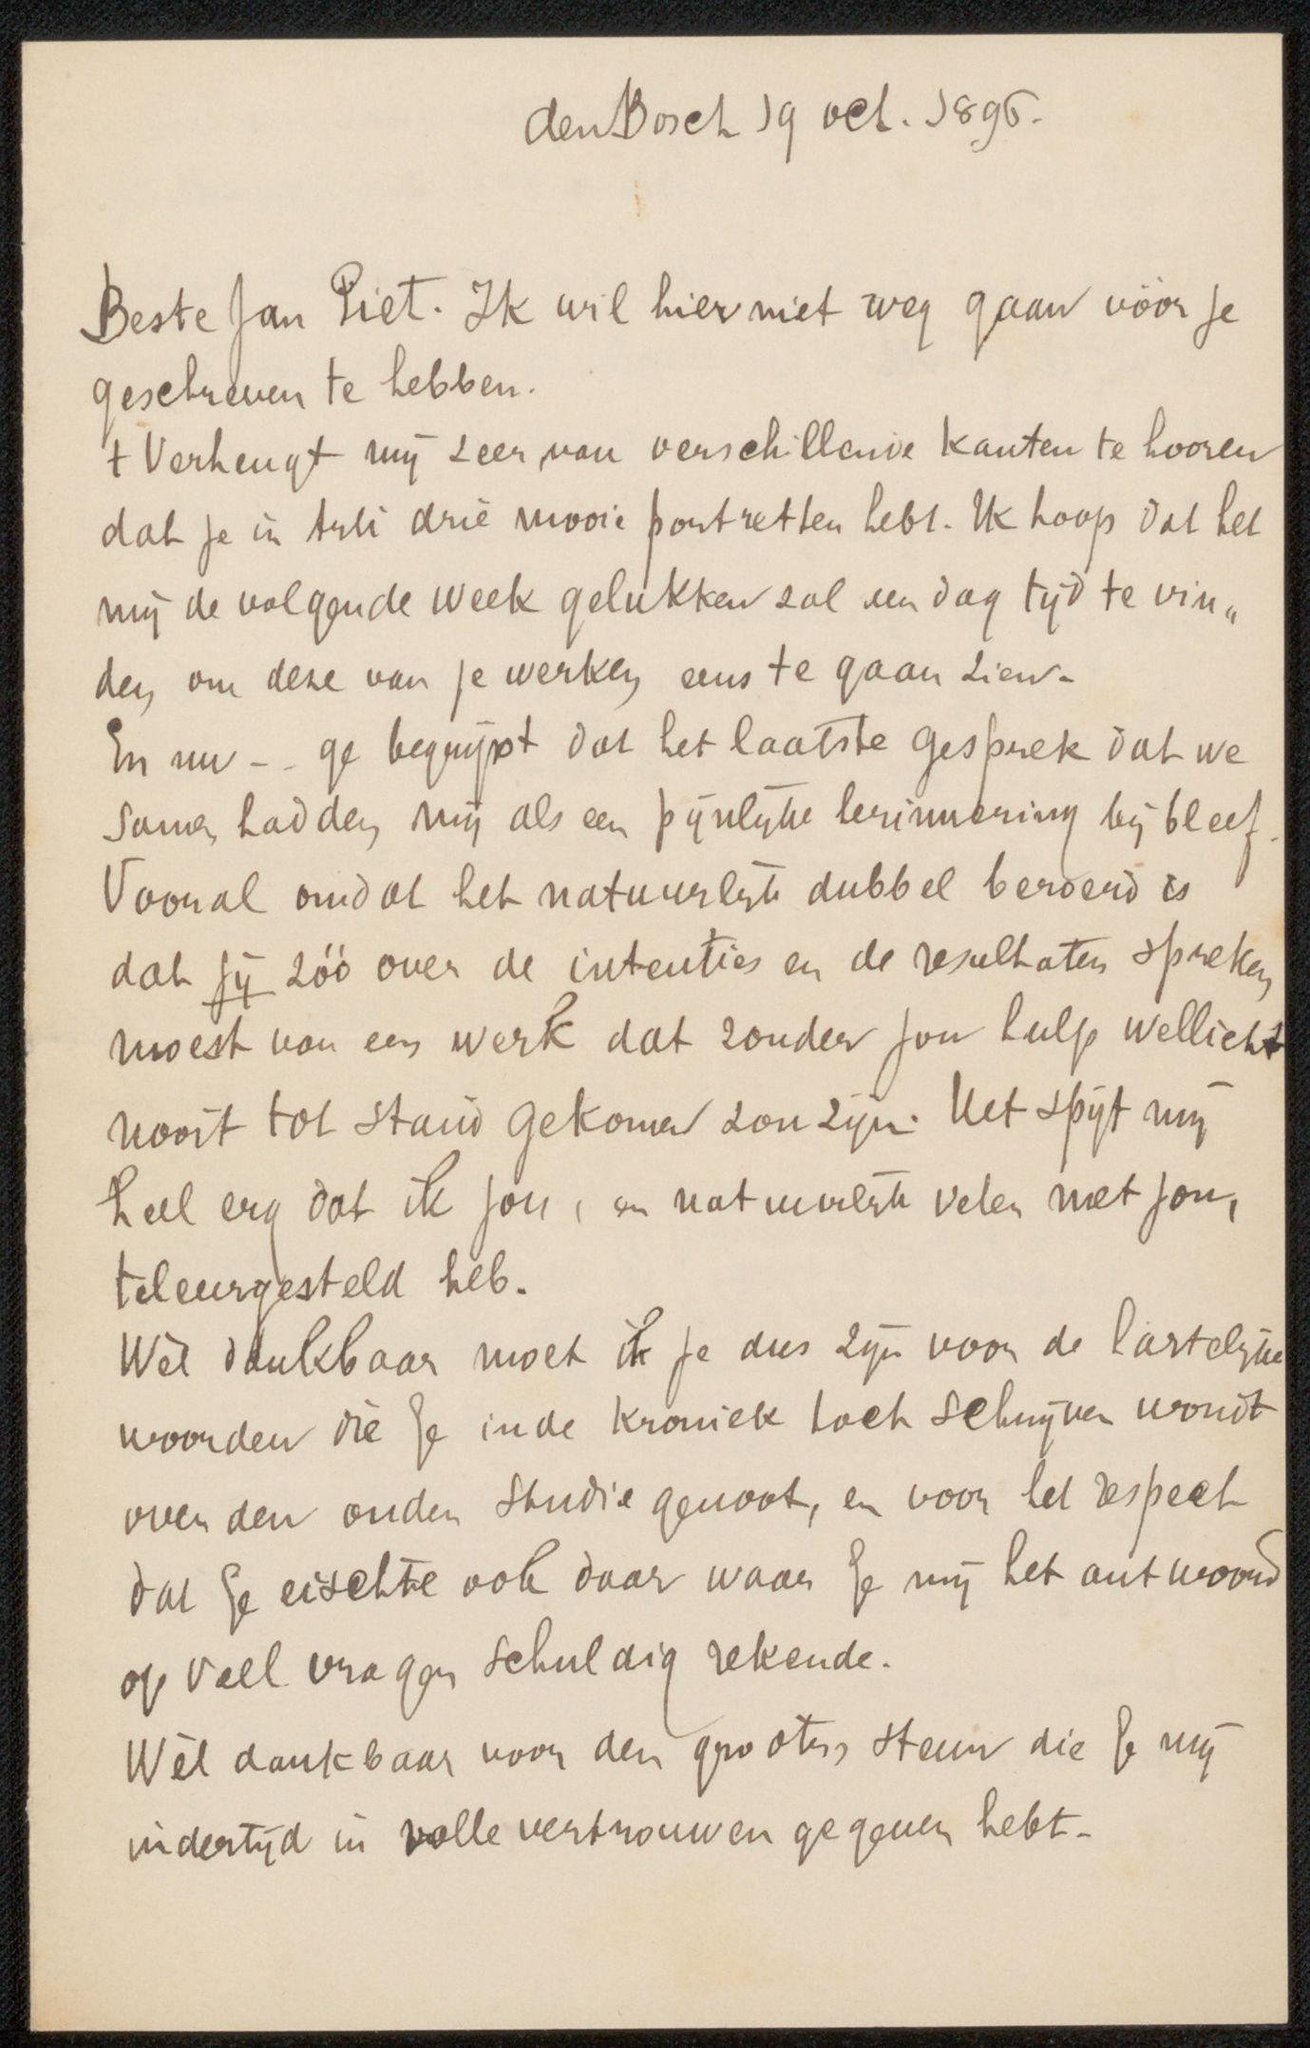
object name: letter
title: Brief aan Jan Veth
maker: antoon derkinderen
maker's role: draughtsman, painter, print maker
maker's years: 1859-1925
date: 1896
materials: ink, paper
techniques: pen, writing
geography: den bosch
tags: designer, jan veth, anonymous historical person portrayed, painting (including book-illumination, miniature-painting), architecture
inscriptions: collector's mark: ‘RPK’